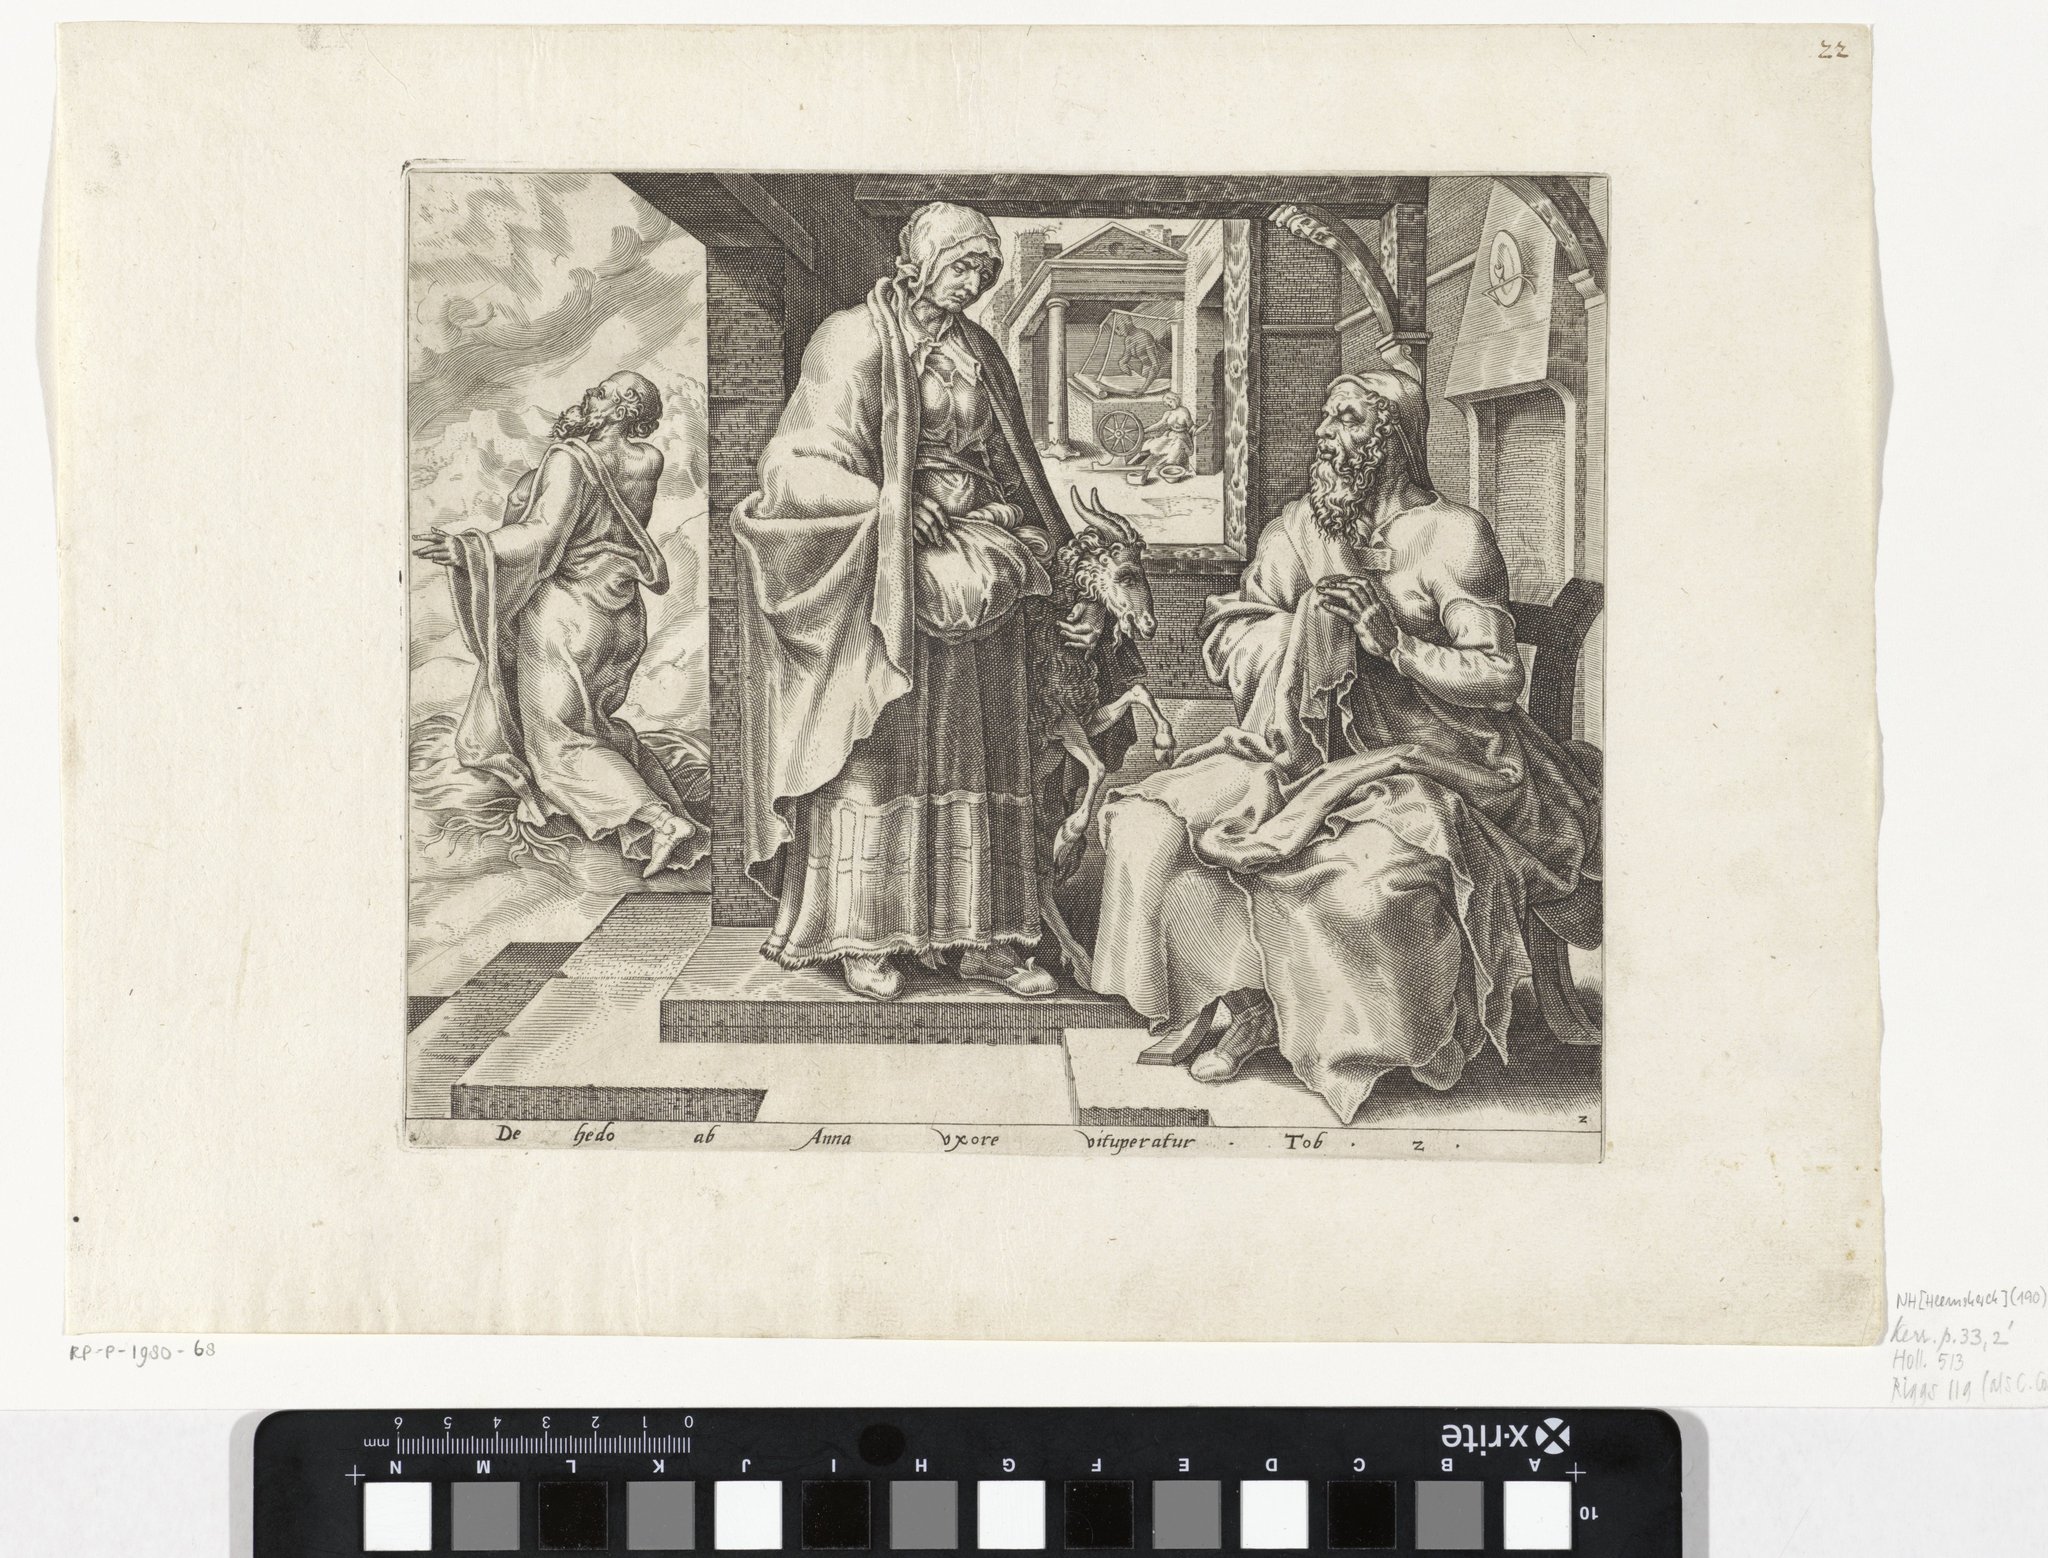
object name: print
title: Verhaal van Tobias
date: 1556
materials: paper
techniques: engraving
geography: low countries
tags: anna brings home a young goat: tobit thinks she has stolen it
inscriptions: collector's mark: Lugt 2760, number: ‘22’, collector's mark: Lugt 2228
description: Anna staat met de geit voor de blinde Tobit, die denkt dat Anna het dier heeft gestolen. Links bidt hij tot God. Onderaan in de marge een éénregelig onderschrift in het Latijn uit Tobit 2.